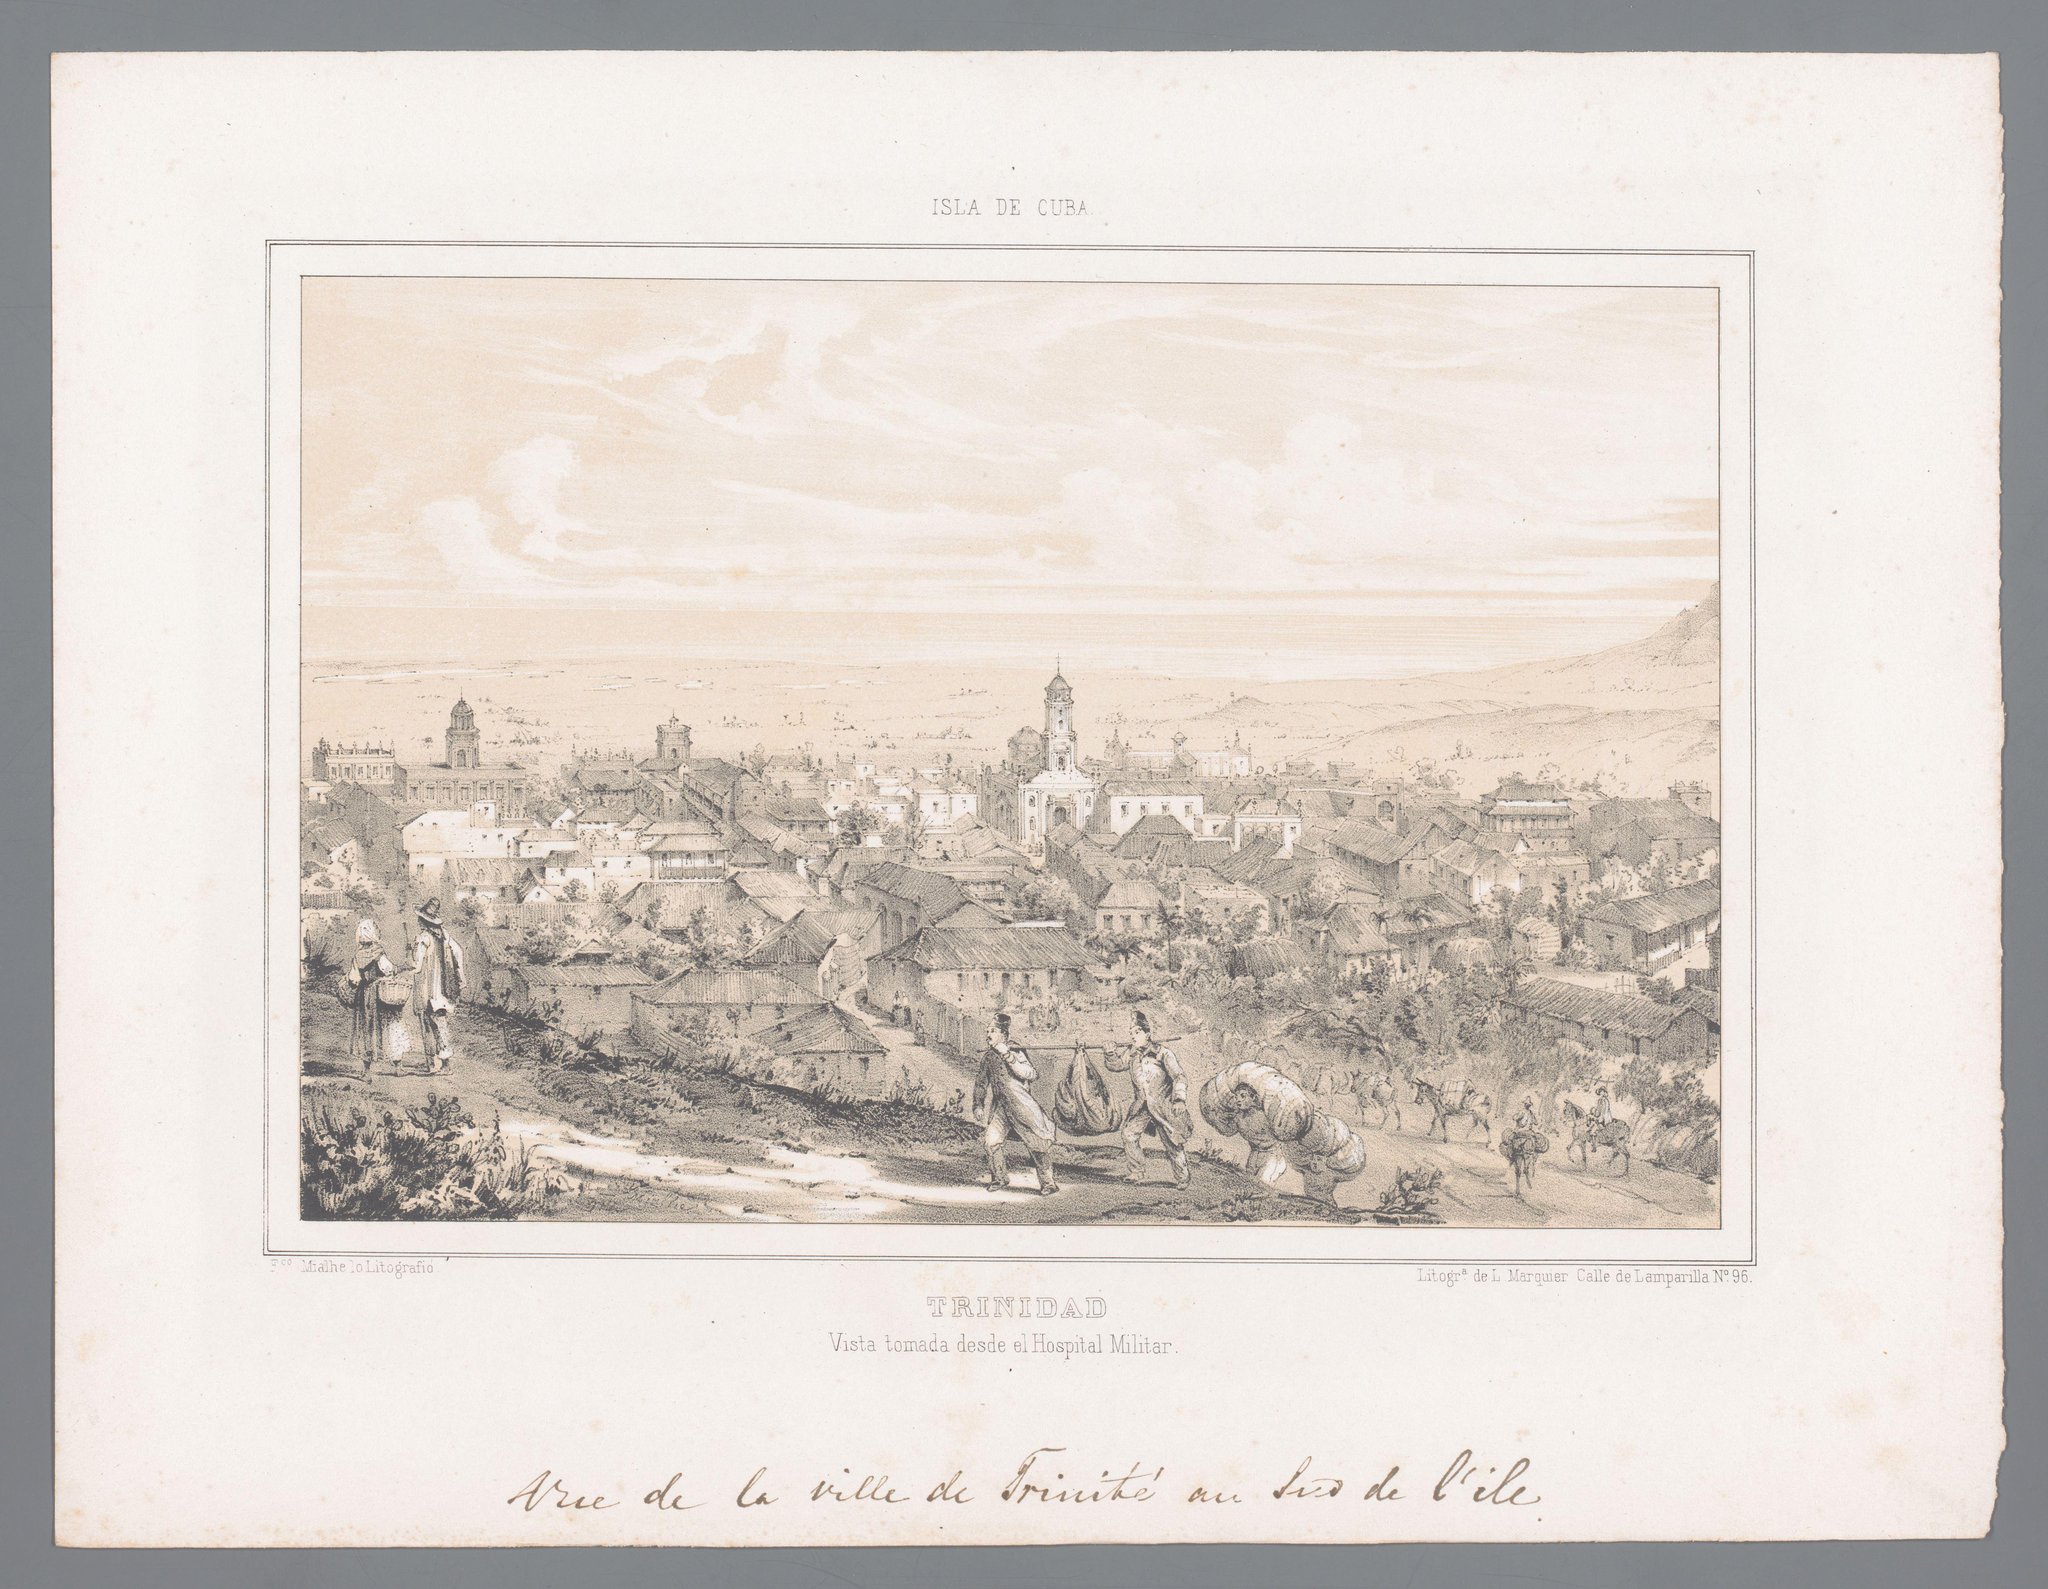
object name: print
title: Trinidad, vista tomada desde el Hospital Militar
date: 1848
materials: paper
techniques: tone lithography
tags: city-view, and landscape with man-made constructions, church (exterior), sea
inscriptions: collector's mark: Lugt 2228